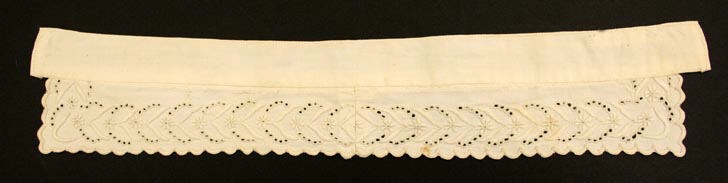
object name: collar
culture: american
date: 1700-1942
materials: linen